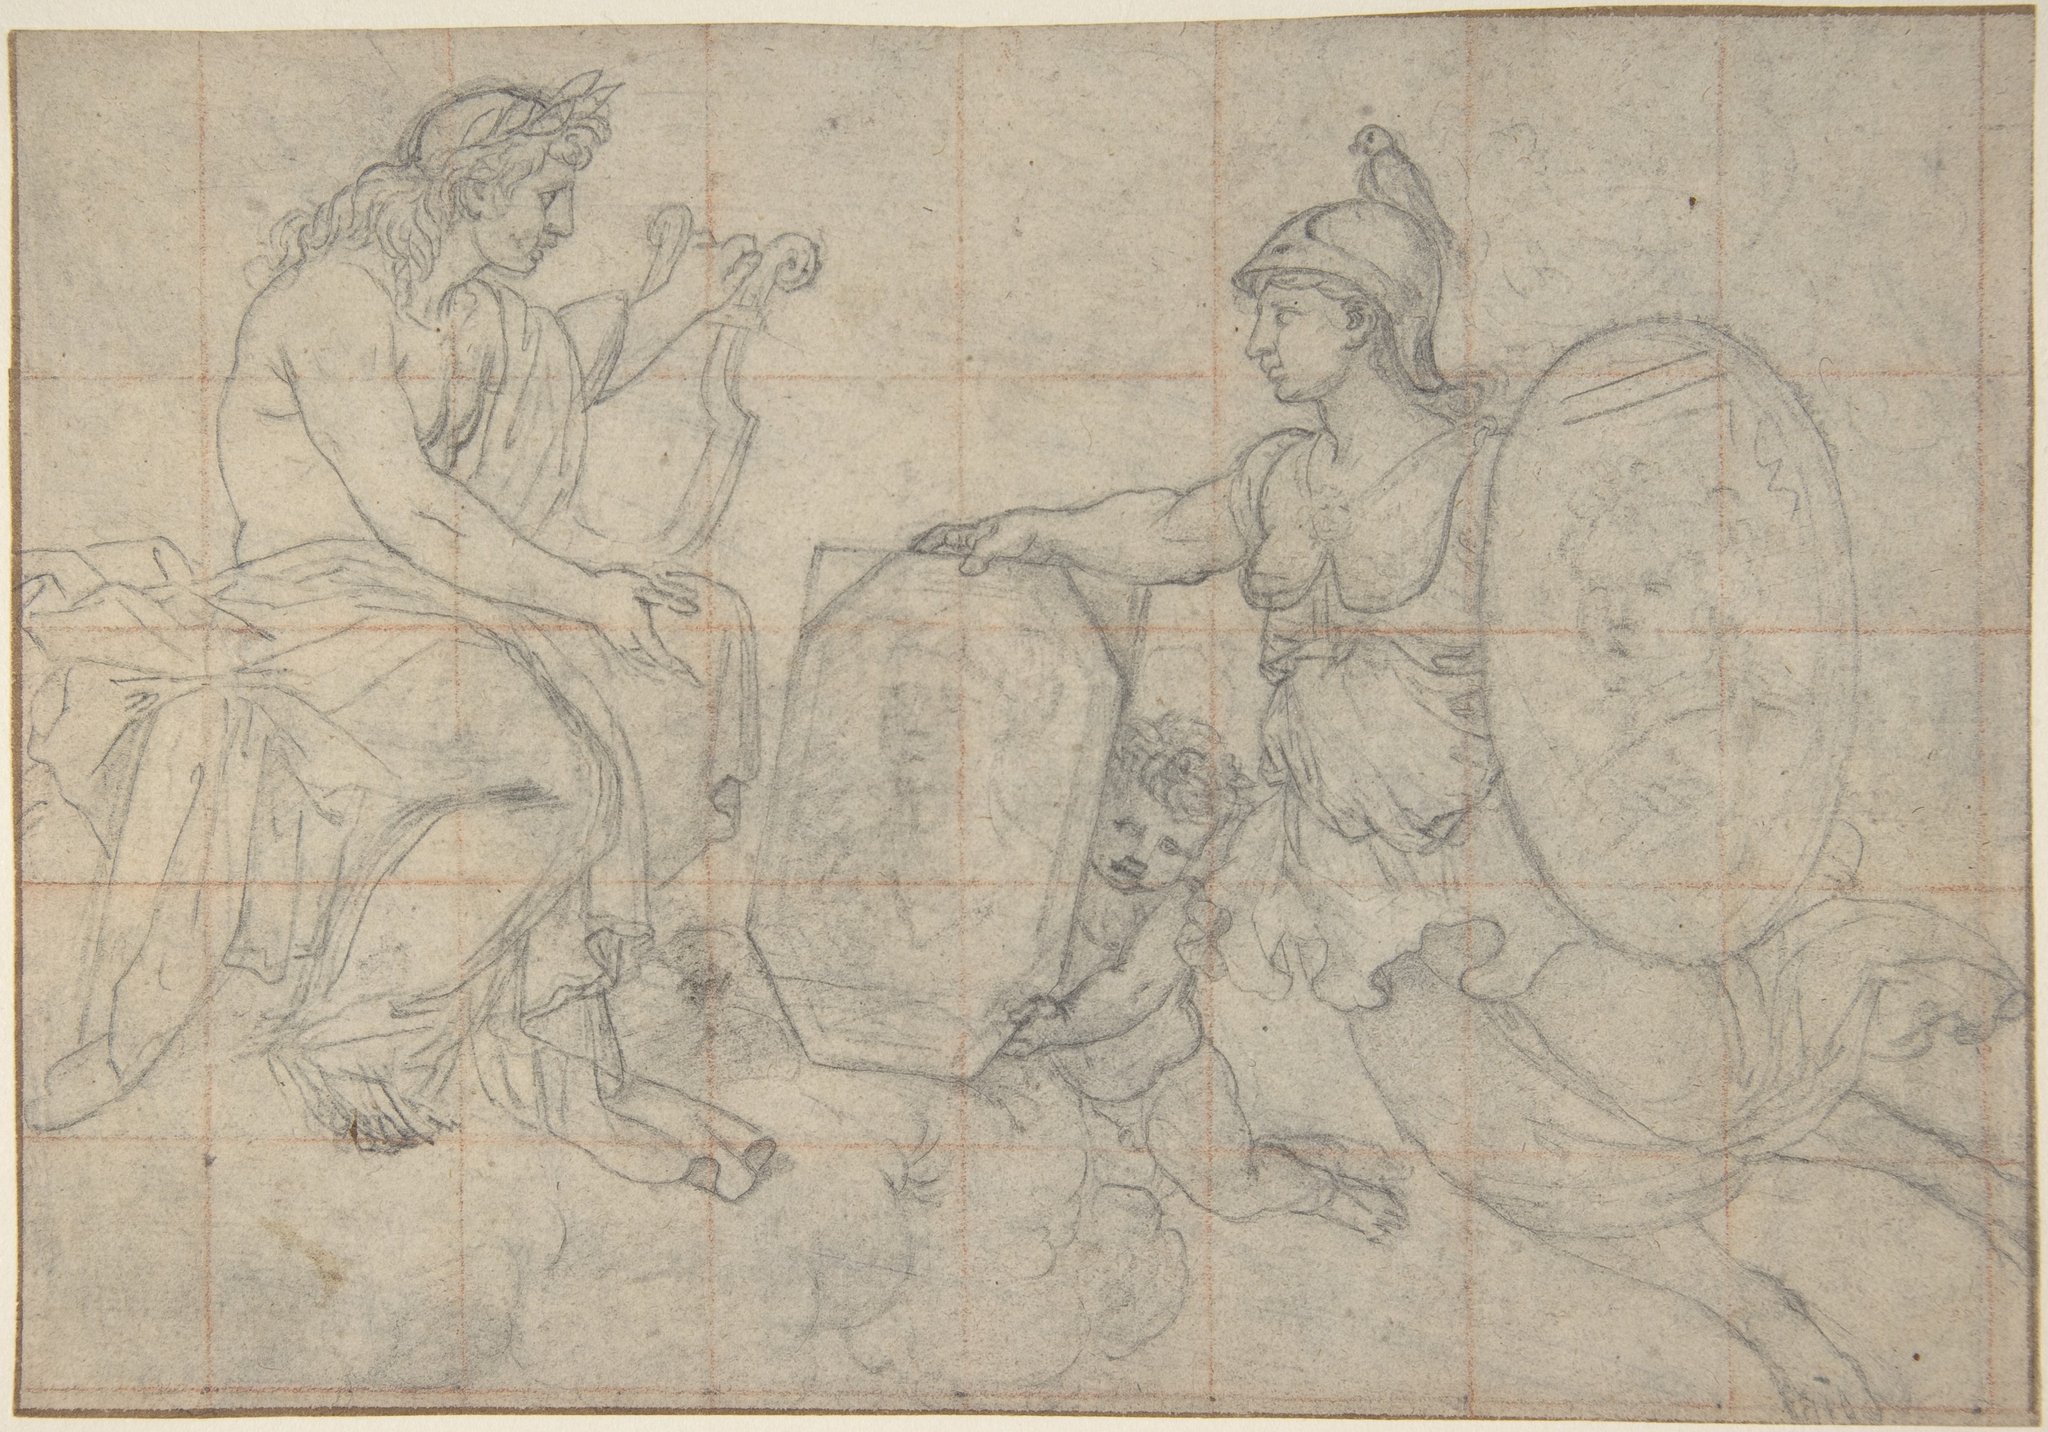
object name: drawing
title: Minerva Presenting Two Portraits to Apollo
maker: eustache le sueur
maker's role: artist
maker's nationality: french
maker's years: 1616-1655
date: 1601-1700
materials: chalk, ink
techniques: incising, pen, drawing, transfer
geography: france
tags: infants,portraits,apollo,minerva